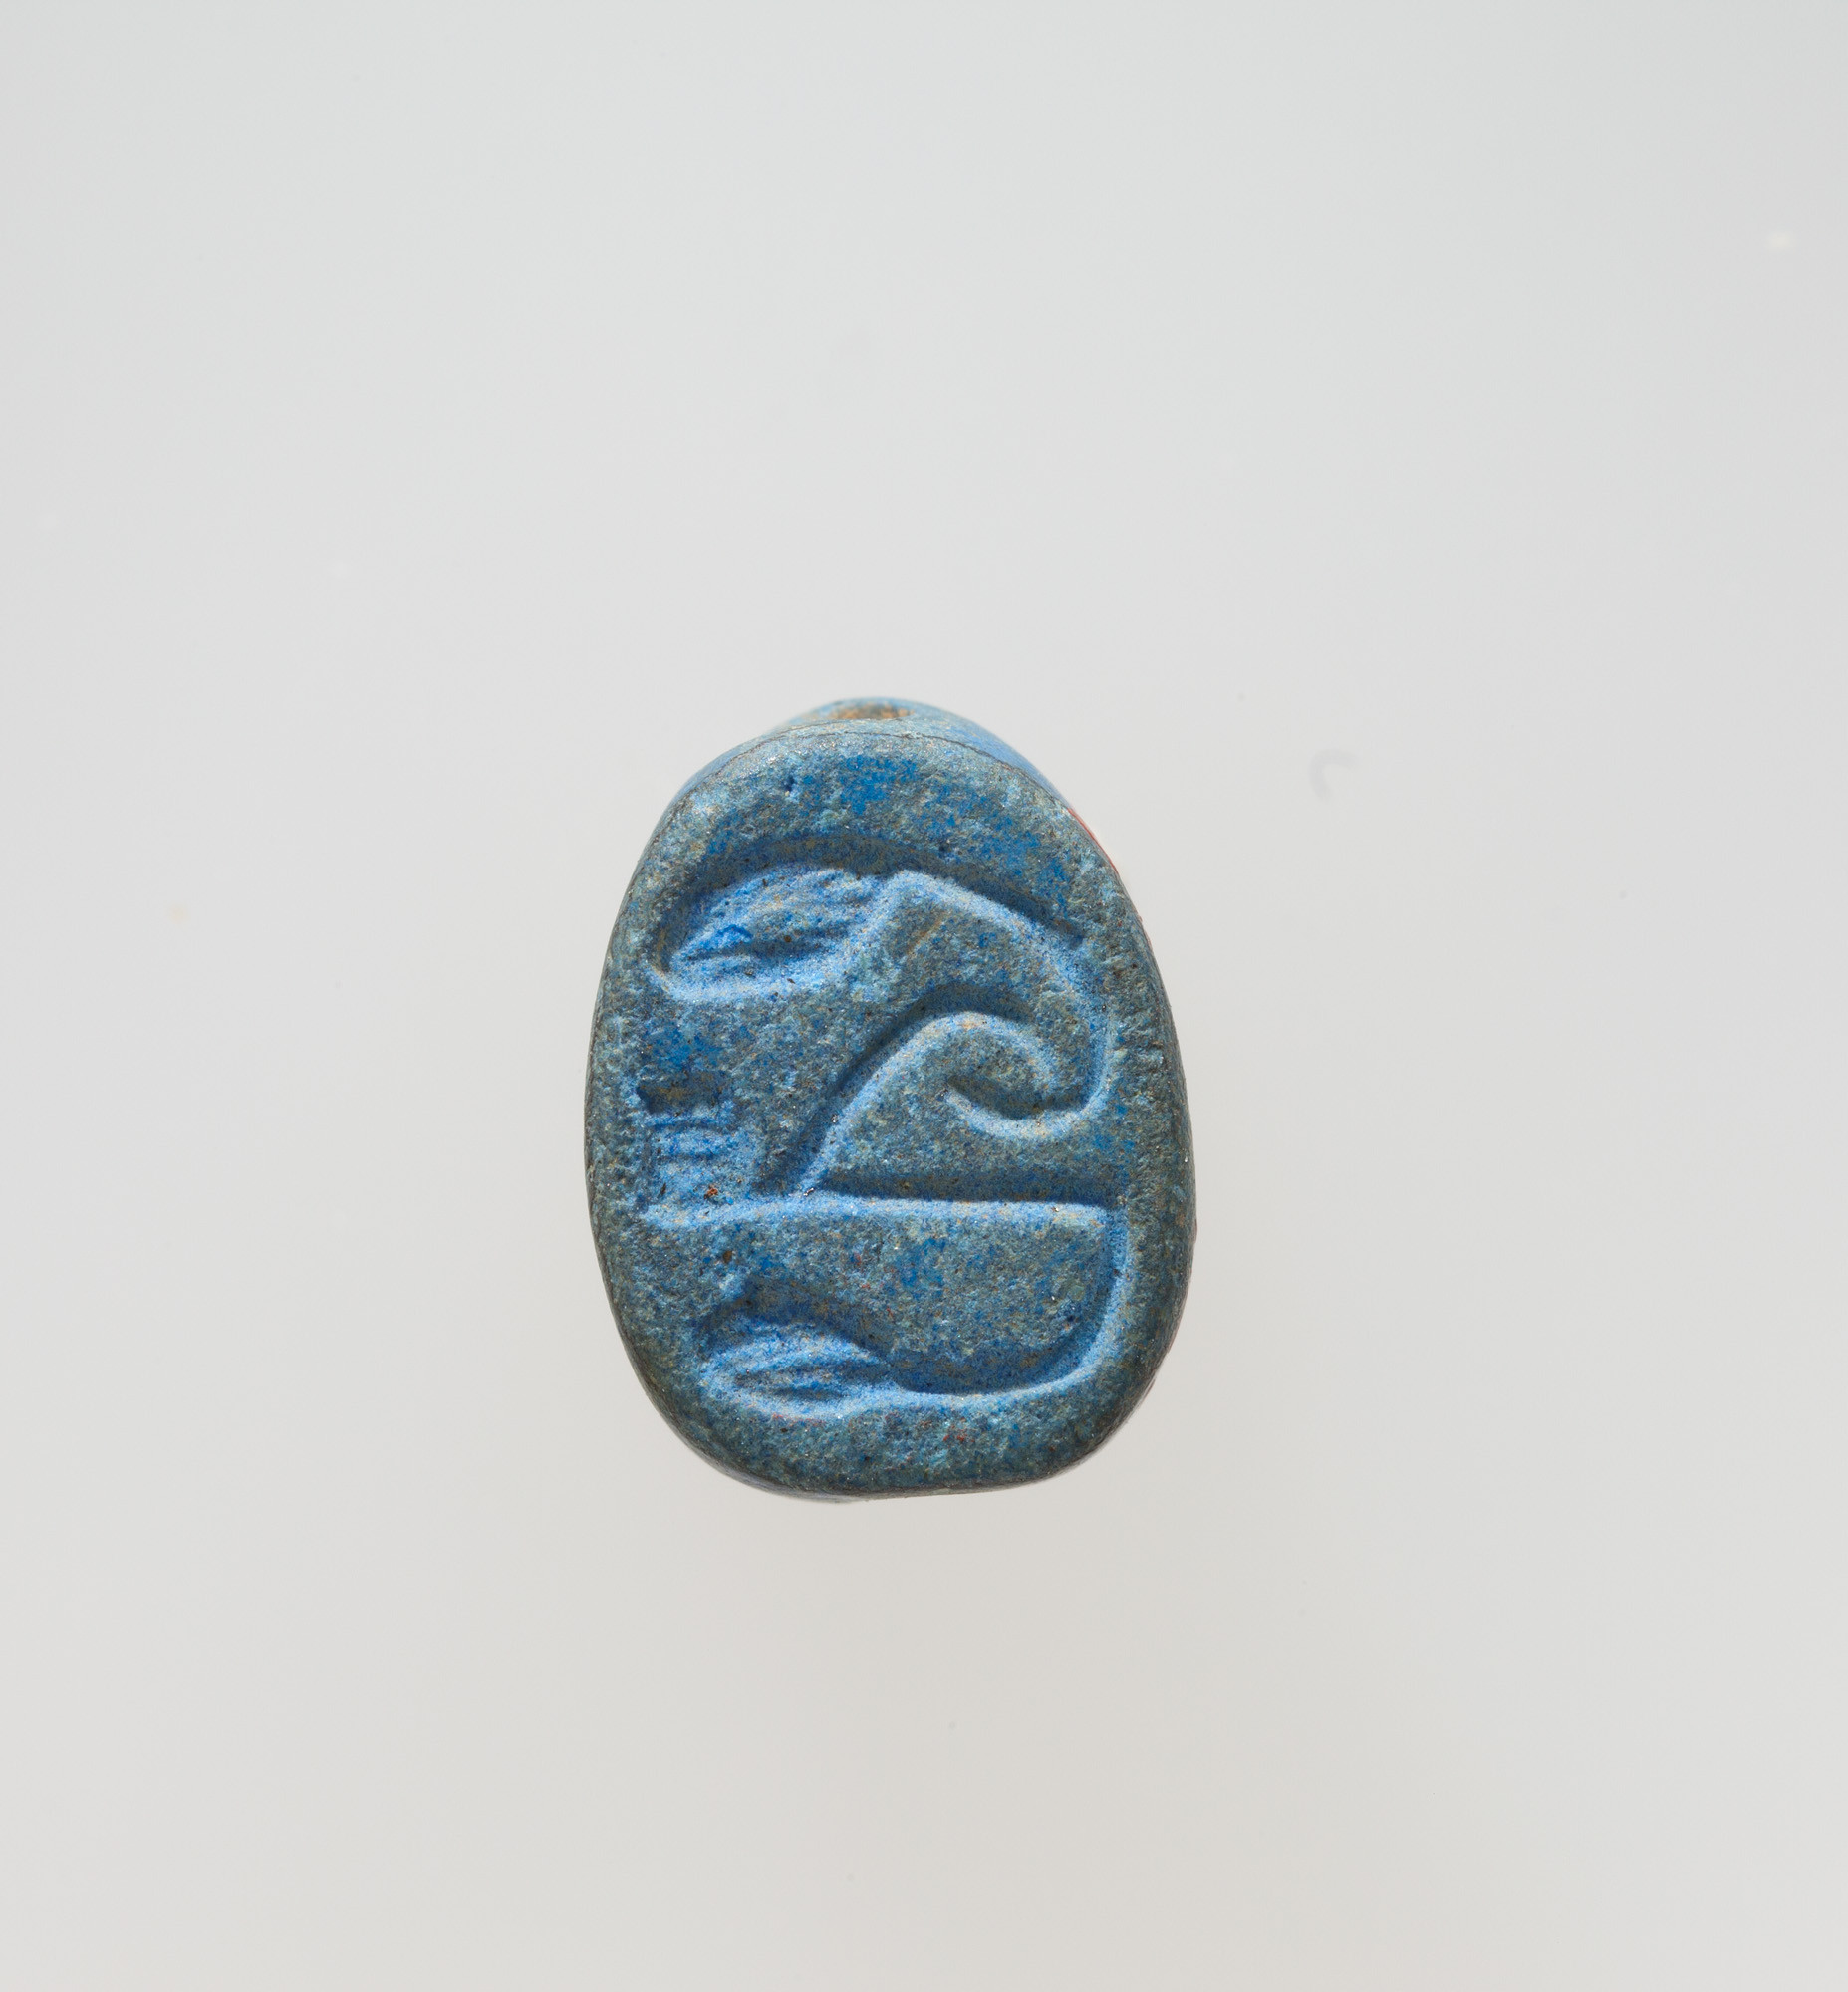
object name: scarab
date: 1479-1458 BCE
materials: faience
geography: egypt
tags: scarabs